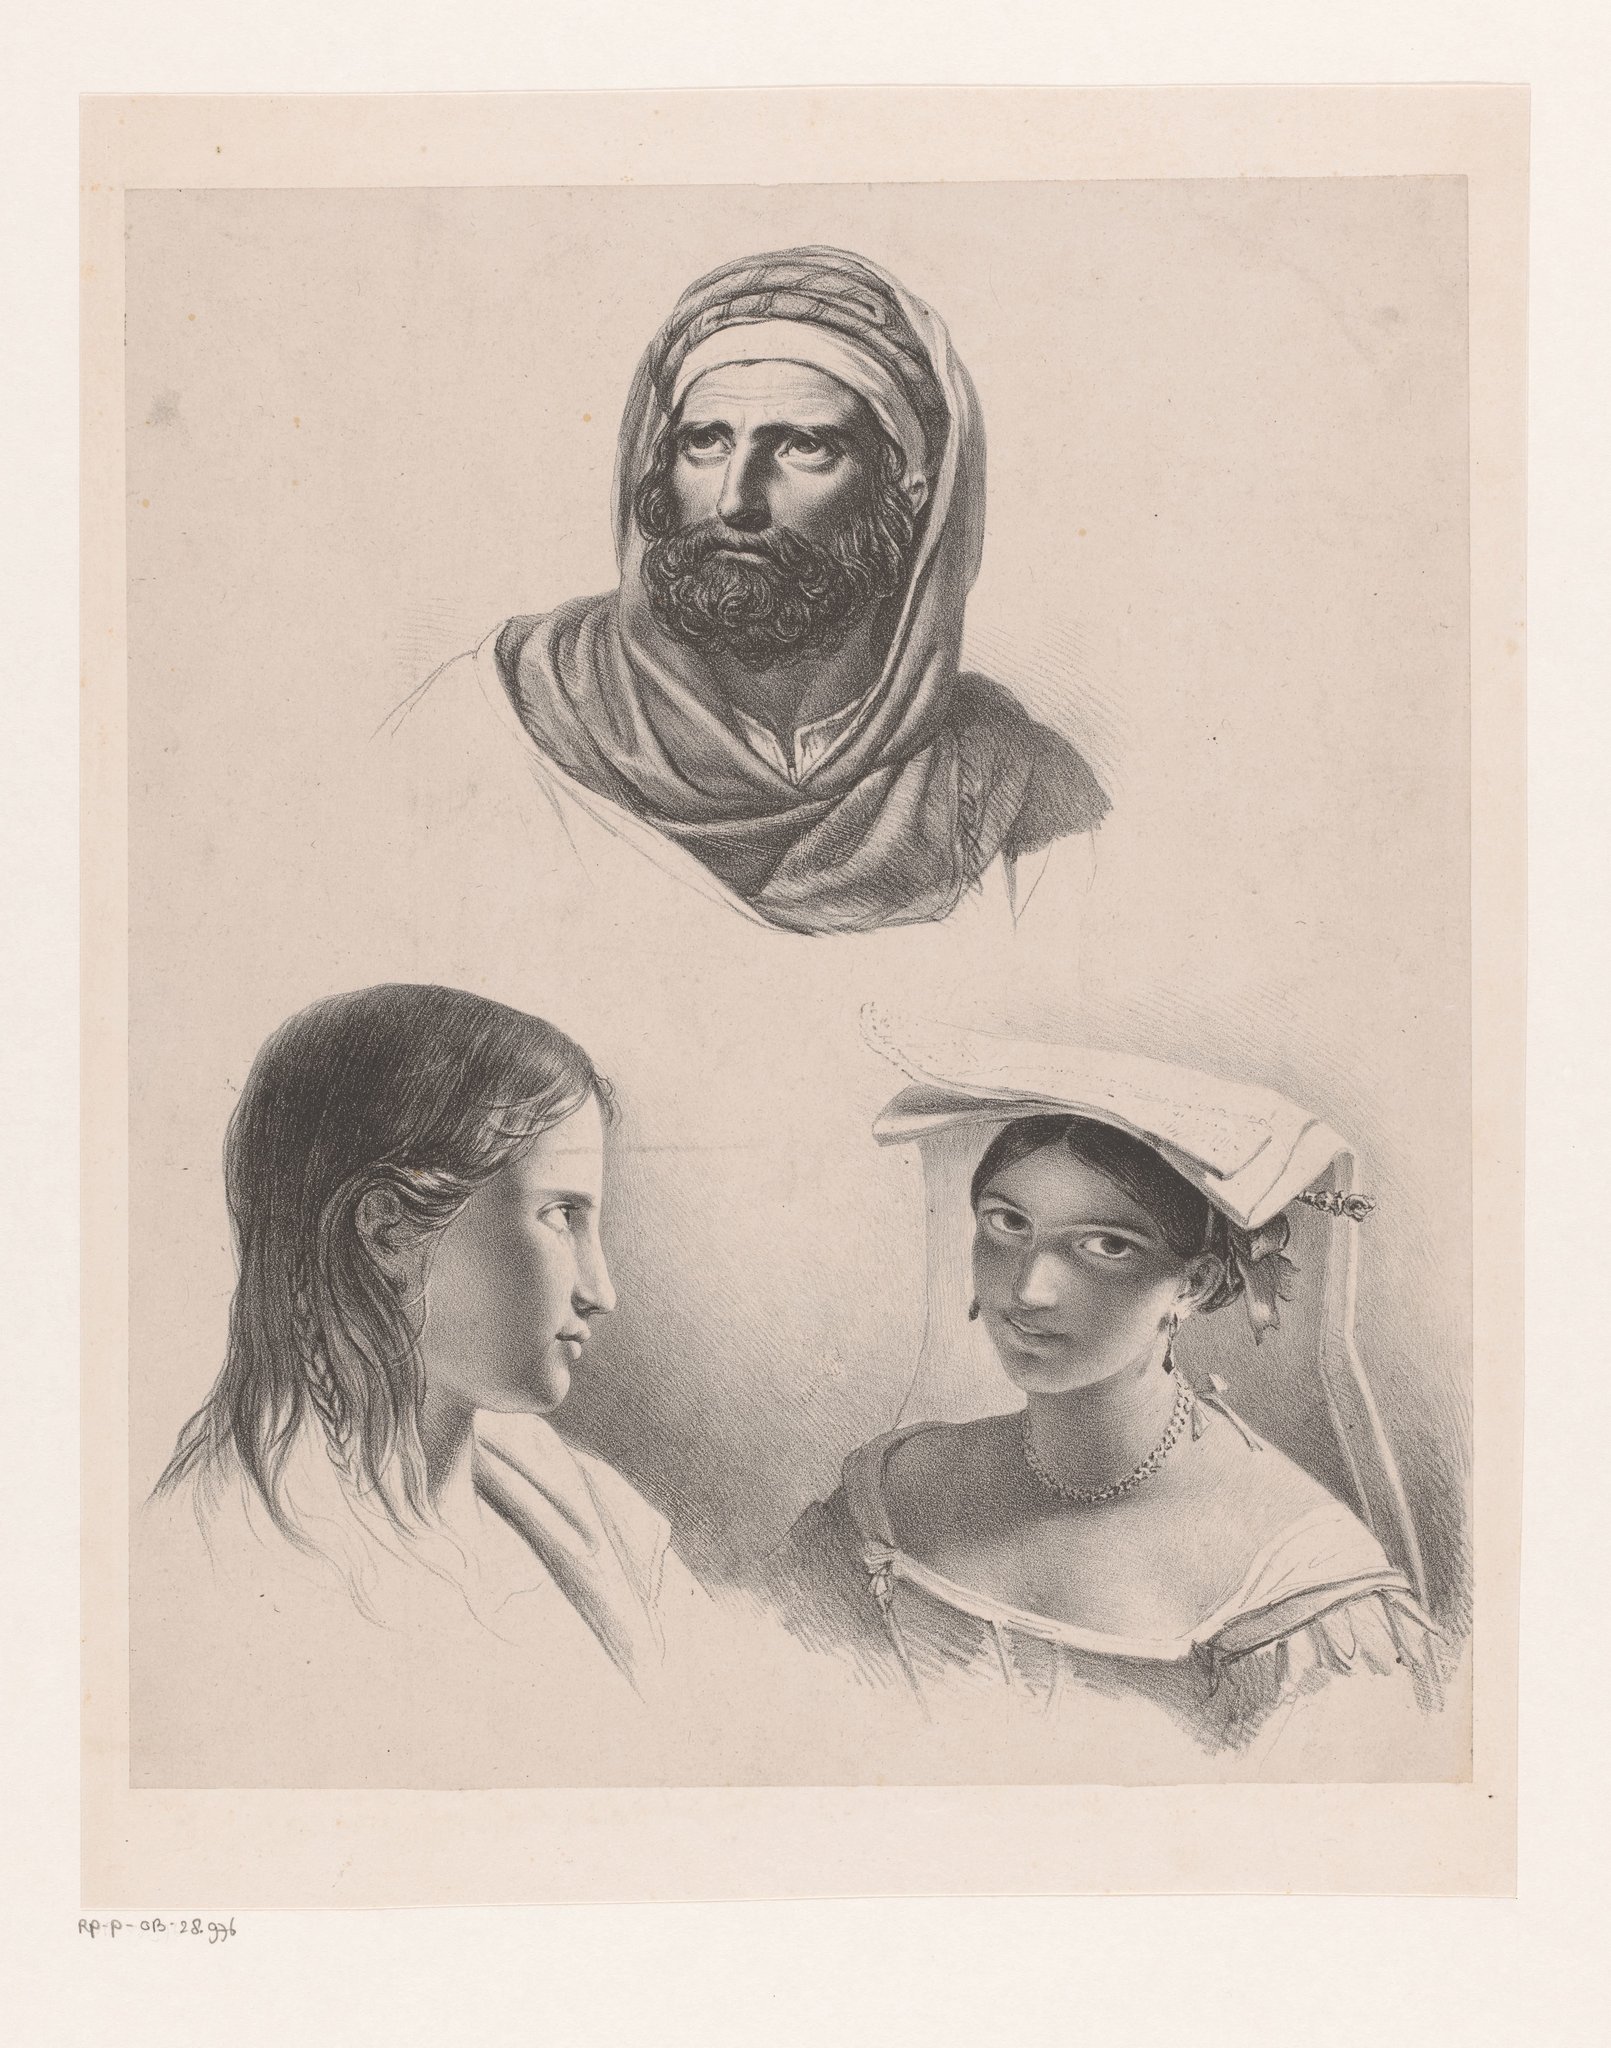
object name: print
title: Drie portretten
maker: cornelis kruseman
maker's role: draughtsman, painter, print maker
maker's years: 1797-1857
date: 1809-1857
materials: paper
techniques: lithograph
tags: historical persons (+ head (and shoulders) (portrait)), old man, europeans (with name) (+ costume)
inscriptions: collector's mark: Lugt 2228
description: Bovenin een oudere man met een baard, linksonder een meisje of jongen met lang haar en rechtsonder een vrouw in Italiaanse kleding.